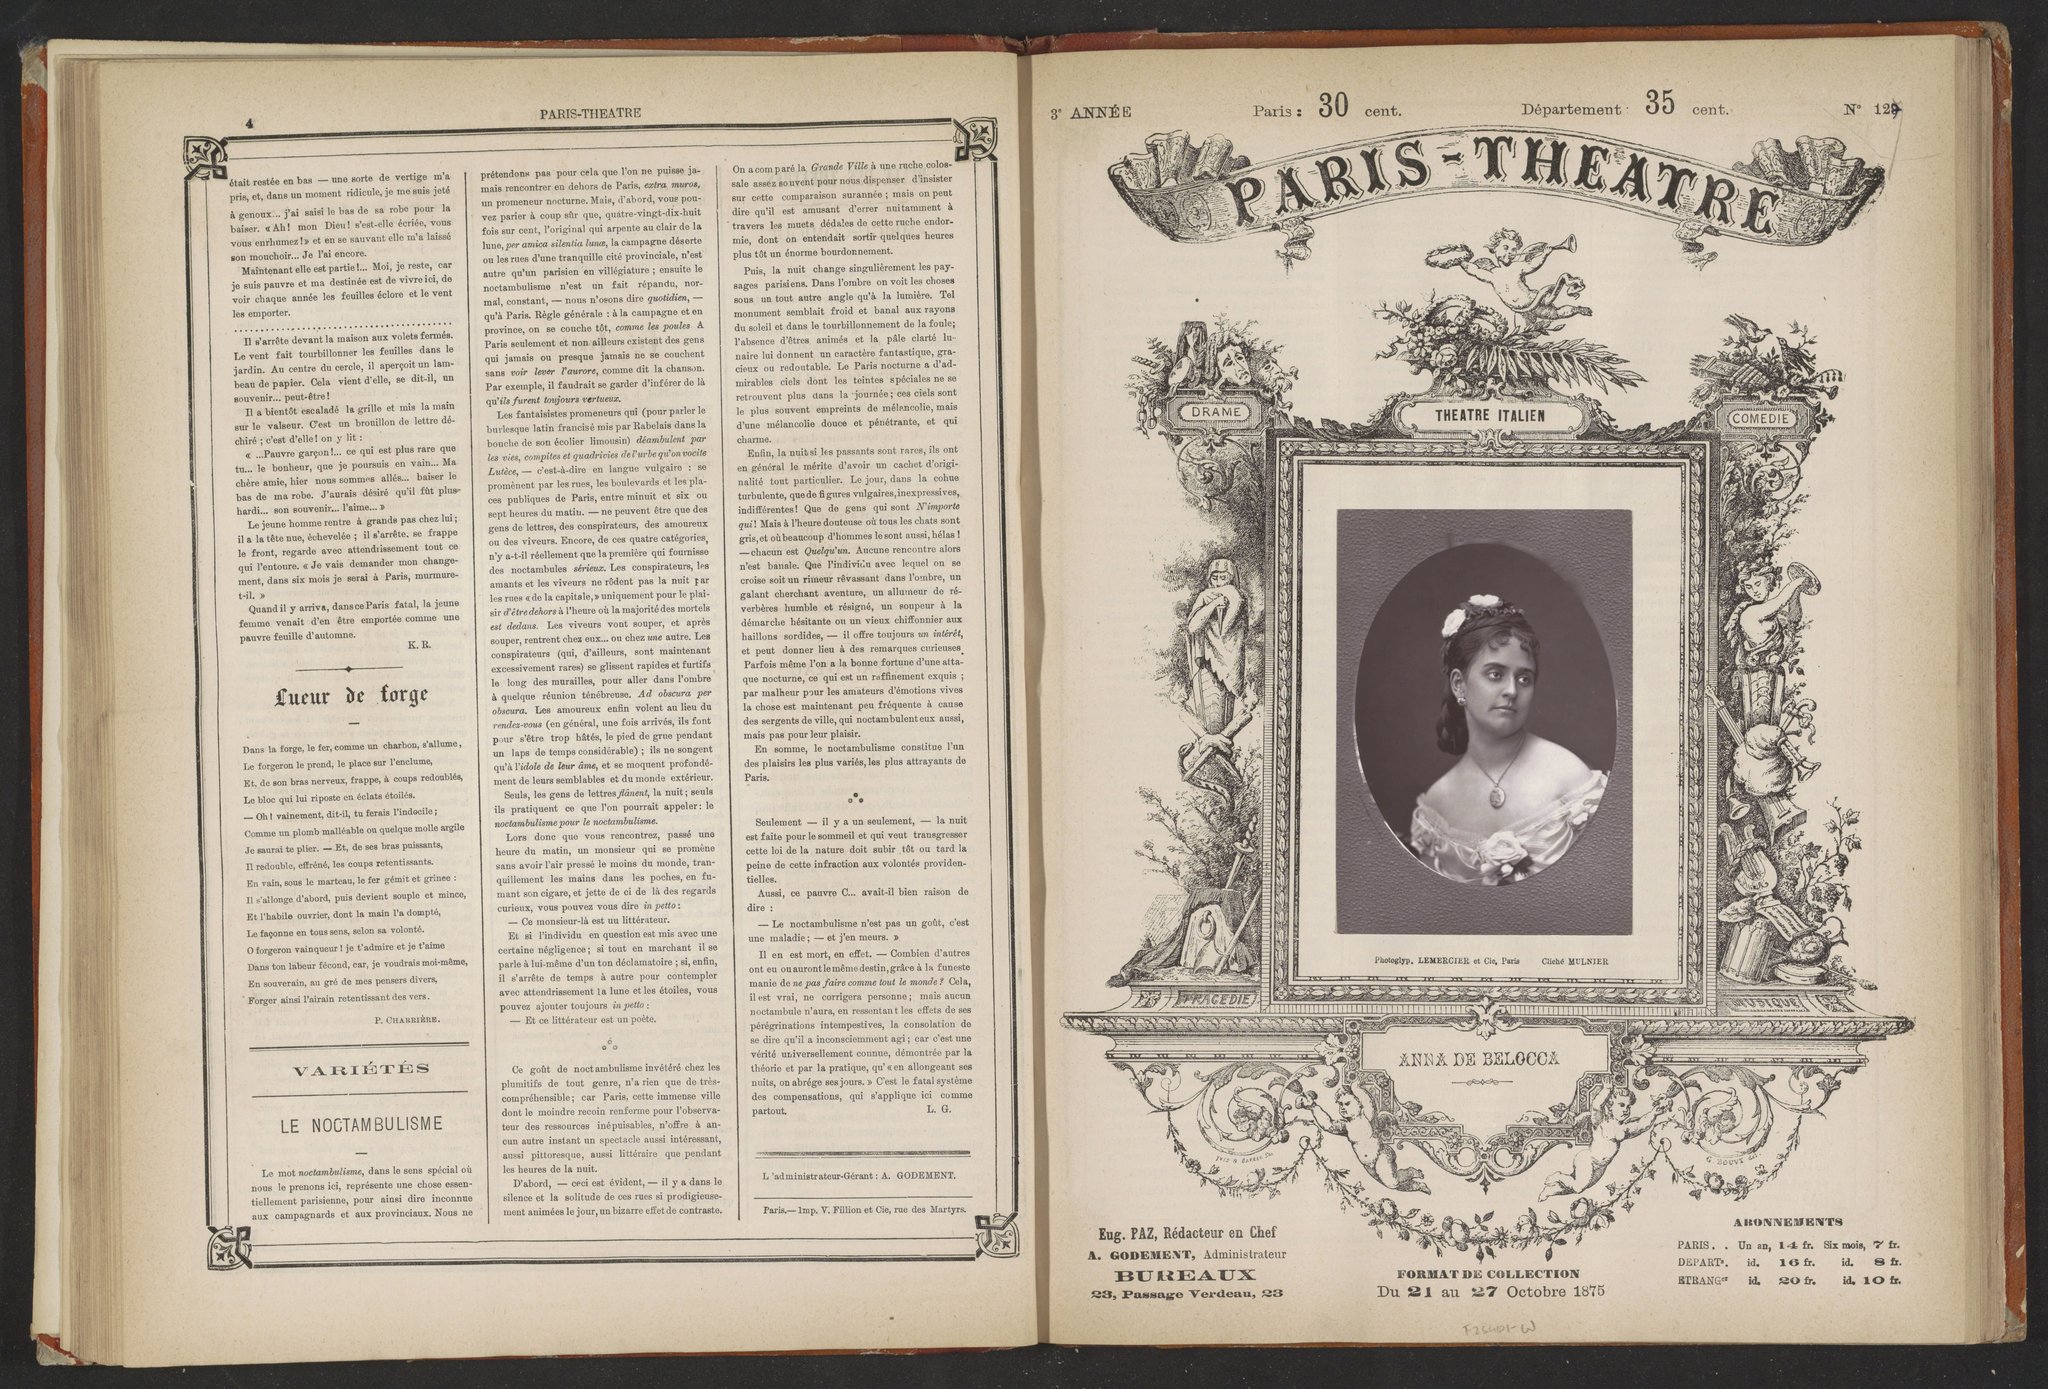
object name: photomechanical print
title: Anna de Belocca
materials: paper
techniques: woodburytype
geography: france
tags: portrait of opera-singer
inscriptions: number: ‘No 127’, inscription: ‘Du 21 au 27 Octobre 1875’